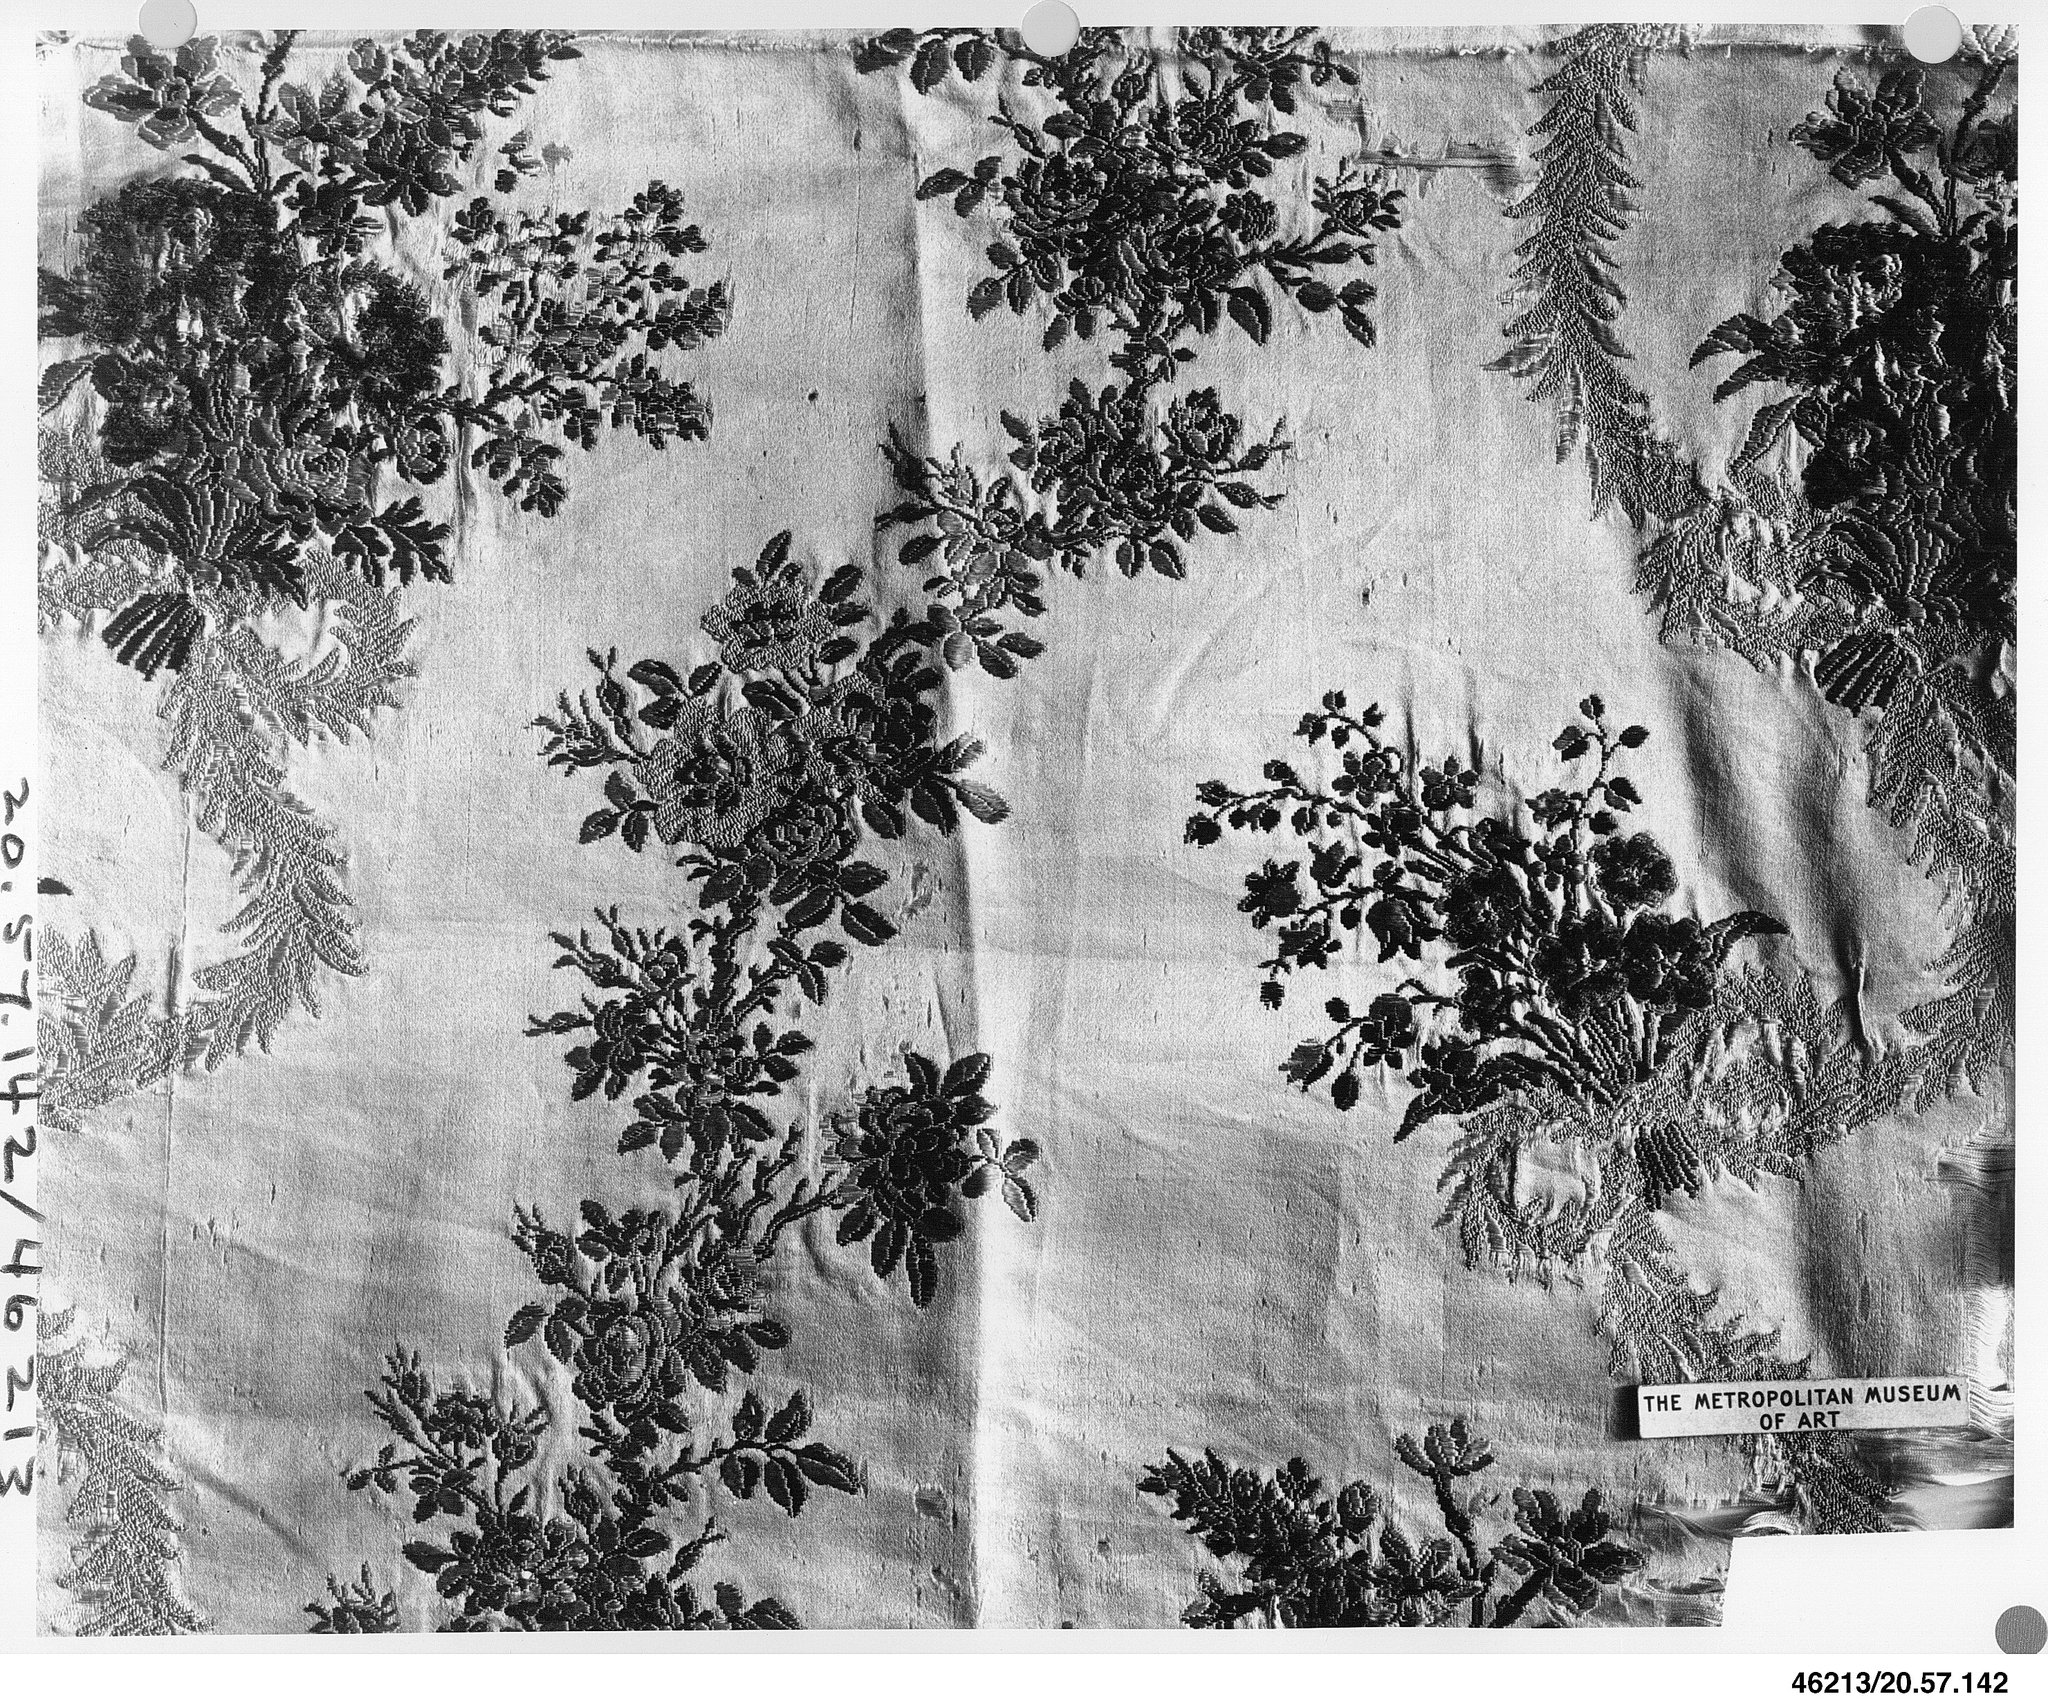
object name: piece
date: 1750-1760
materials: silk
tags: flowers,leaves